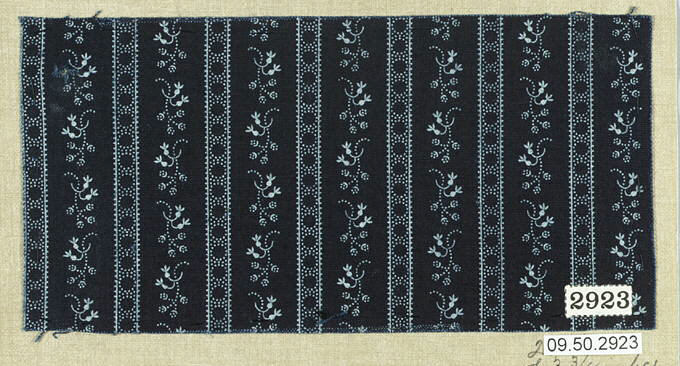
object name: piece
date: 1801-1900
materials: cotton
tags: flowers,leaves